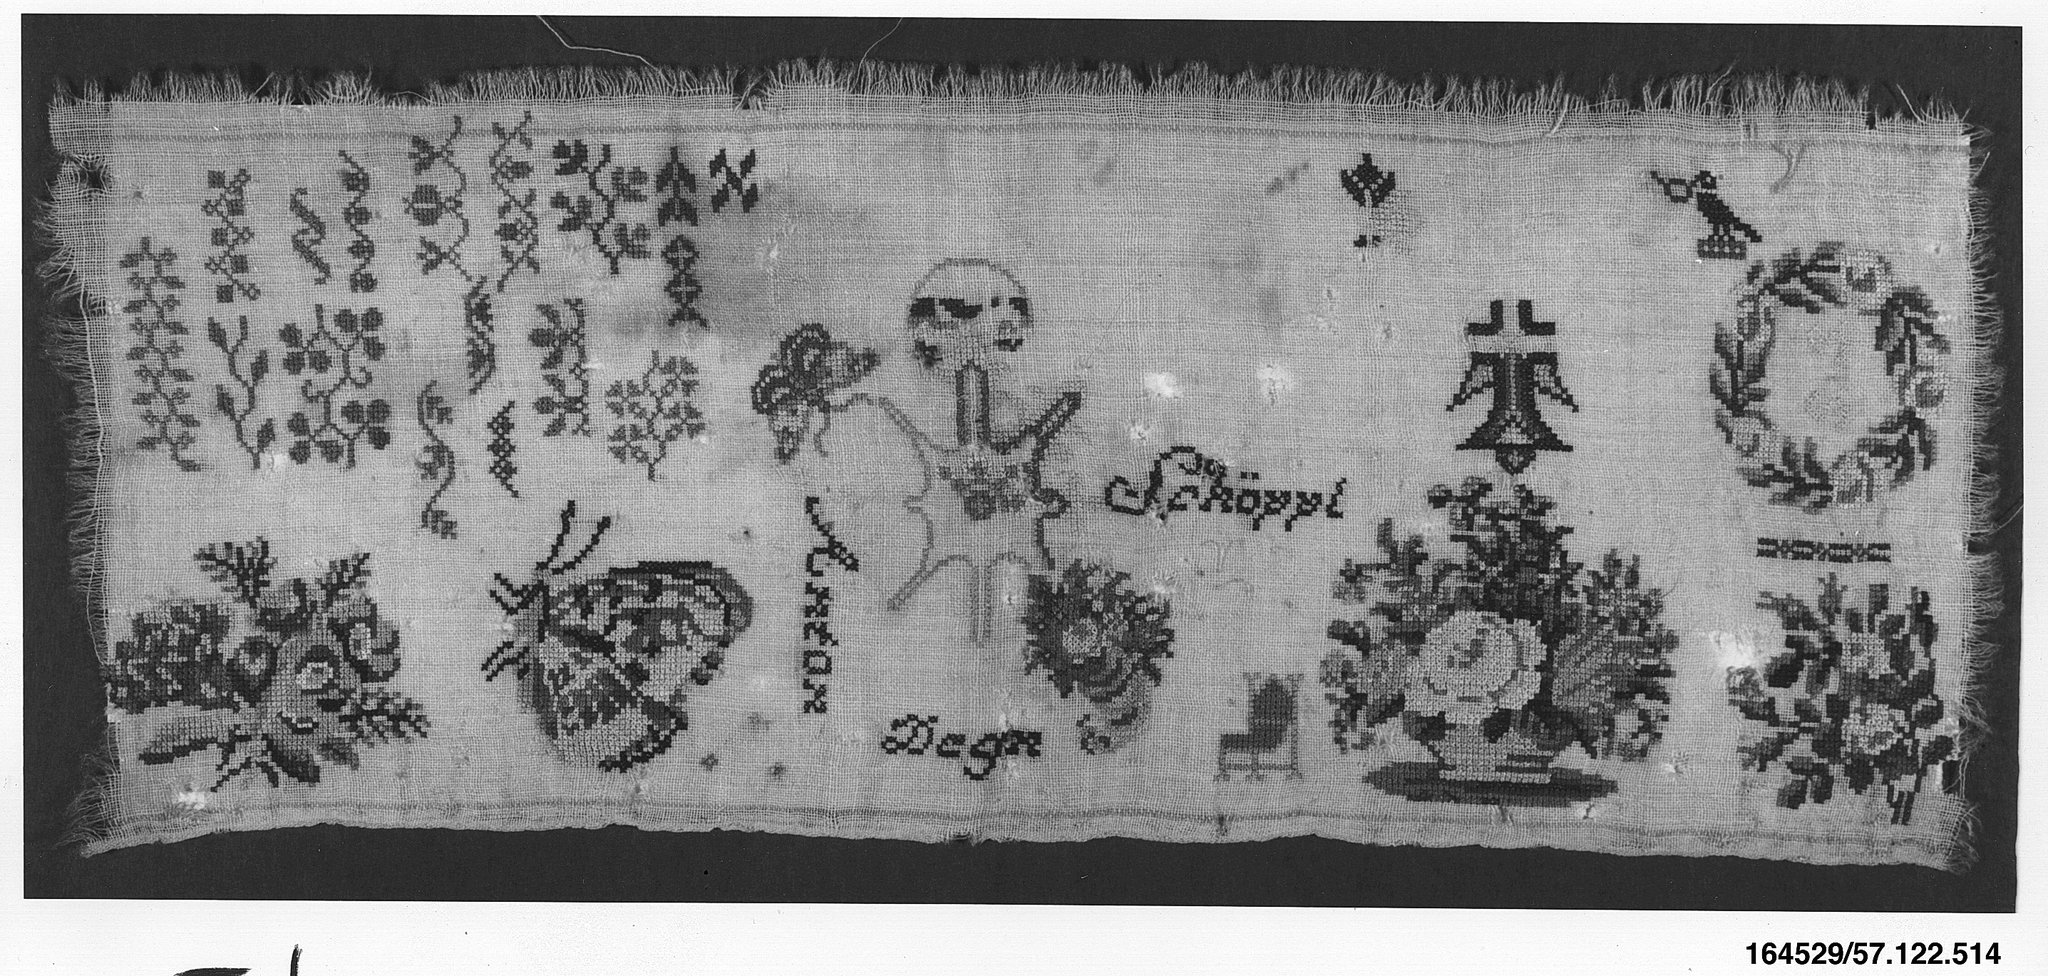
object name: sampler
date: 1801-1900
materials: canvas, silk, wool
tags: butterflies,flowers